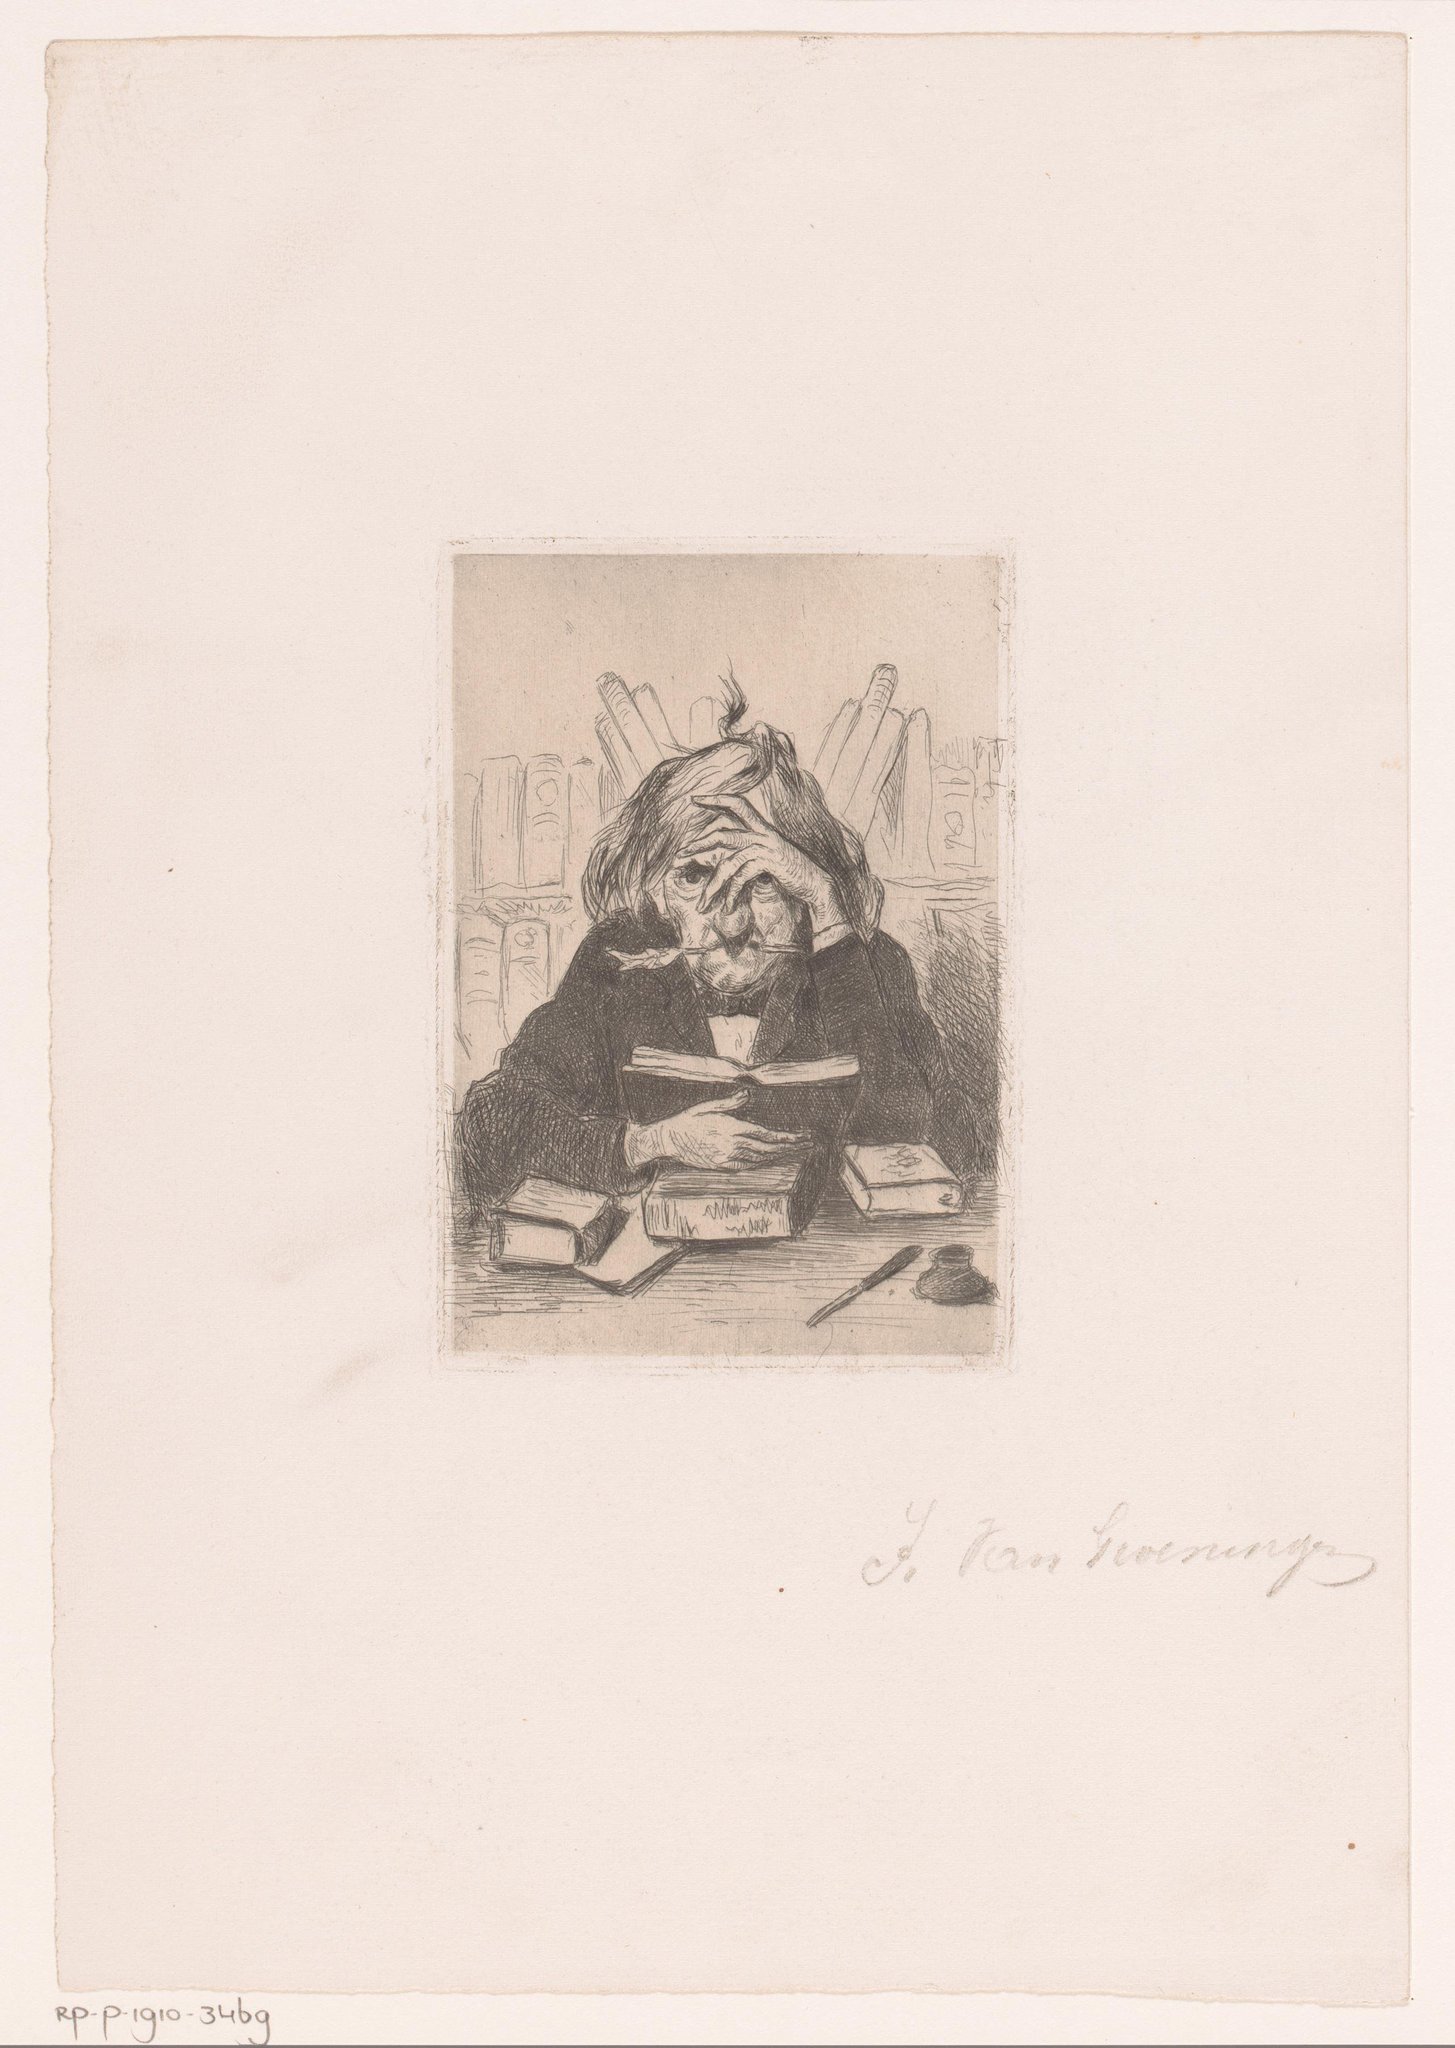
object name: print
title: Lezende man in een bibliotheek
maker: fr. van groeningen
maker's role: print maker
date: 1850-1910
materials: paper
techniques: etching, intaglio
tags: reading, study; 'studiolo'; library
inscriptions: collector's mark: Lugt 2228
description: Aangezien geboorte- en sterfdatum van de kunstenaar onbekend zijn, is voor de rechtenbepaling van dit object de verwervingsdatum gehanteerd.